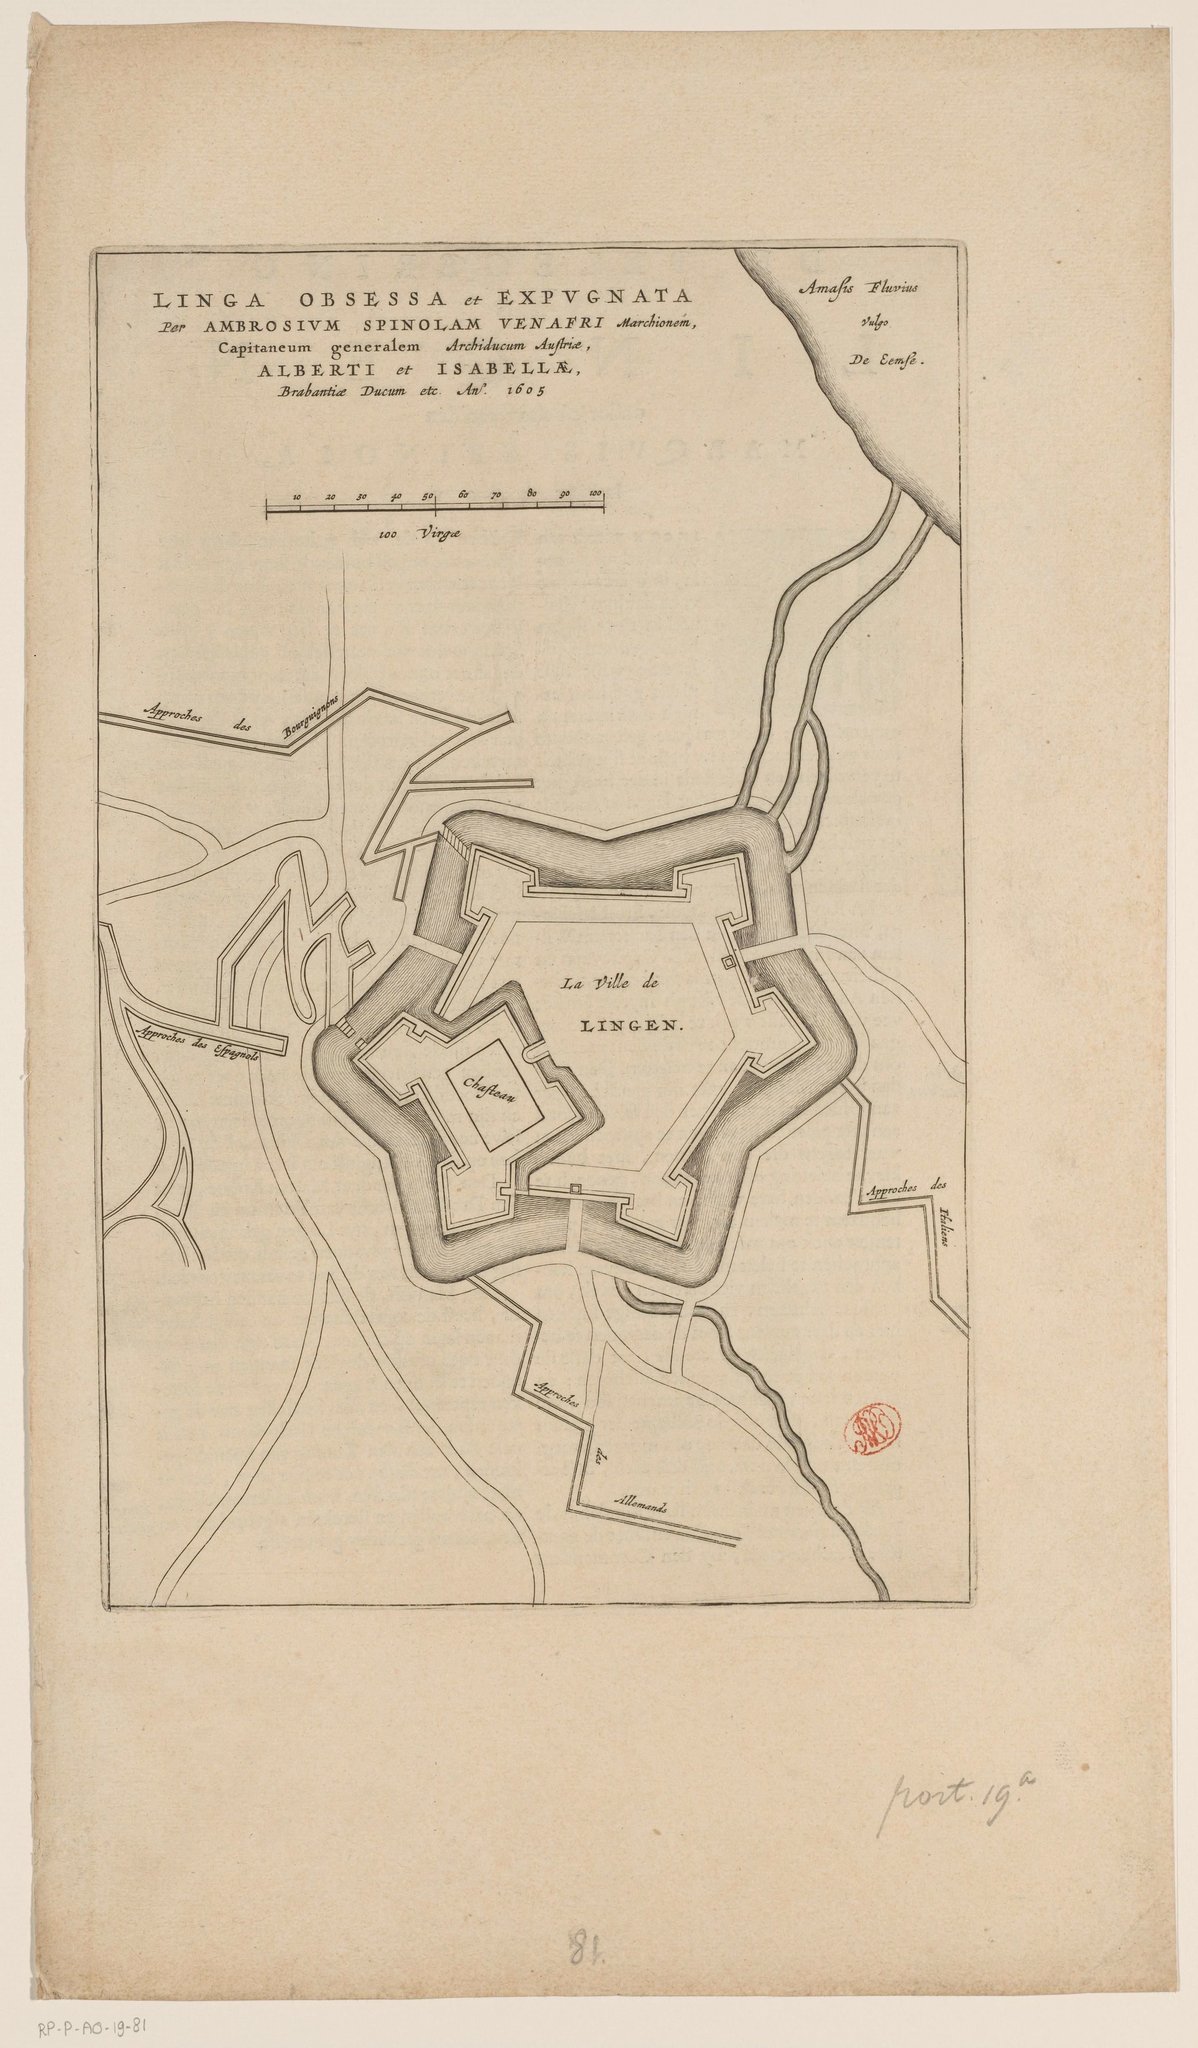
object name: area plan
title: Vestingplattegrond van Lingen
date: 1652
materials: paper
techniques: engraving, letterpress printing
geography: amsterdam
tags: fortified city, maps of cities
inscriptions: collector's mark: Lugt 195, collector's mark: Lugt 2228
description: Prent gebruikt in: Blaeu, Johannes Willemszoon. Toonneel der steden van de Vereenighde Nederlanden. 2 delen. Amsterdam: Johannes Willemszoon Blaeu, 1652, dl. 2.